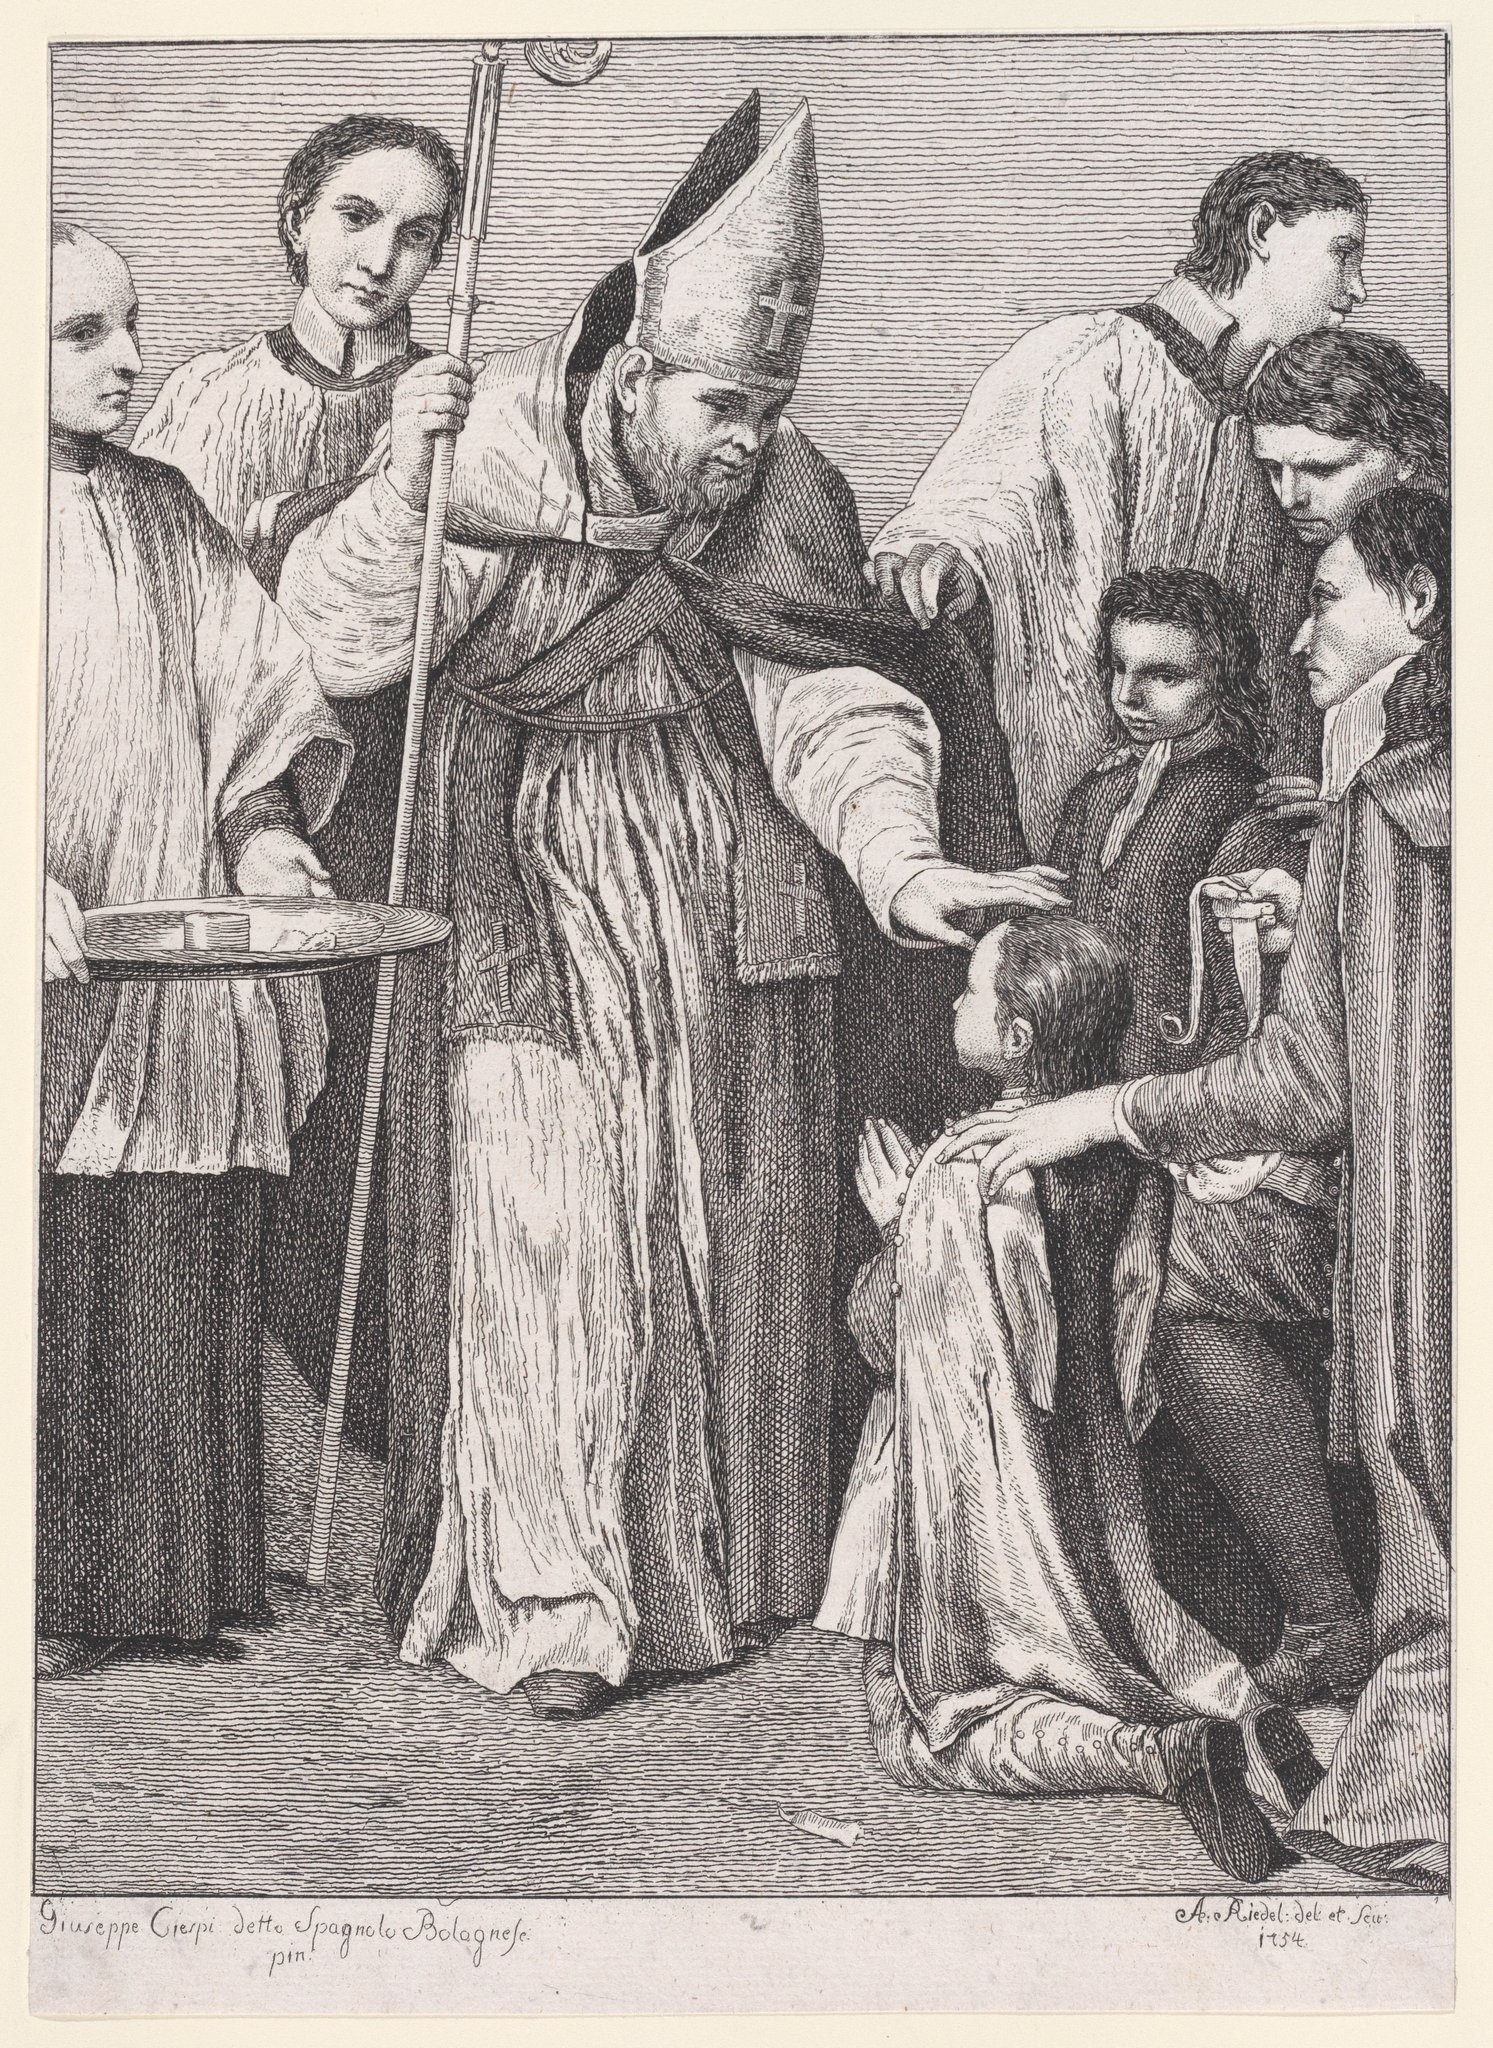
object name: print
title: Confirmation, from "The Seven Sacraments"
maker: johann anton riedel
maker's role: artist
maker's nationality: swiss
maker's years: 1736-1816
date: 1754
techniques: etching